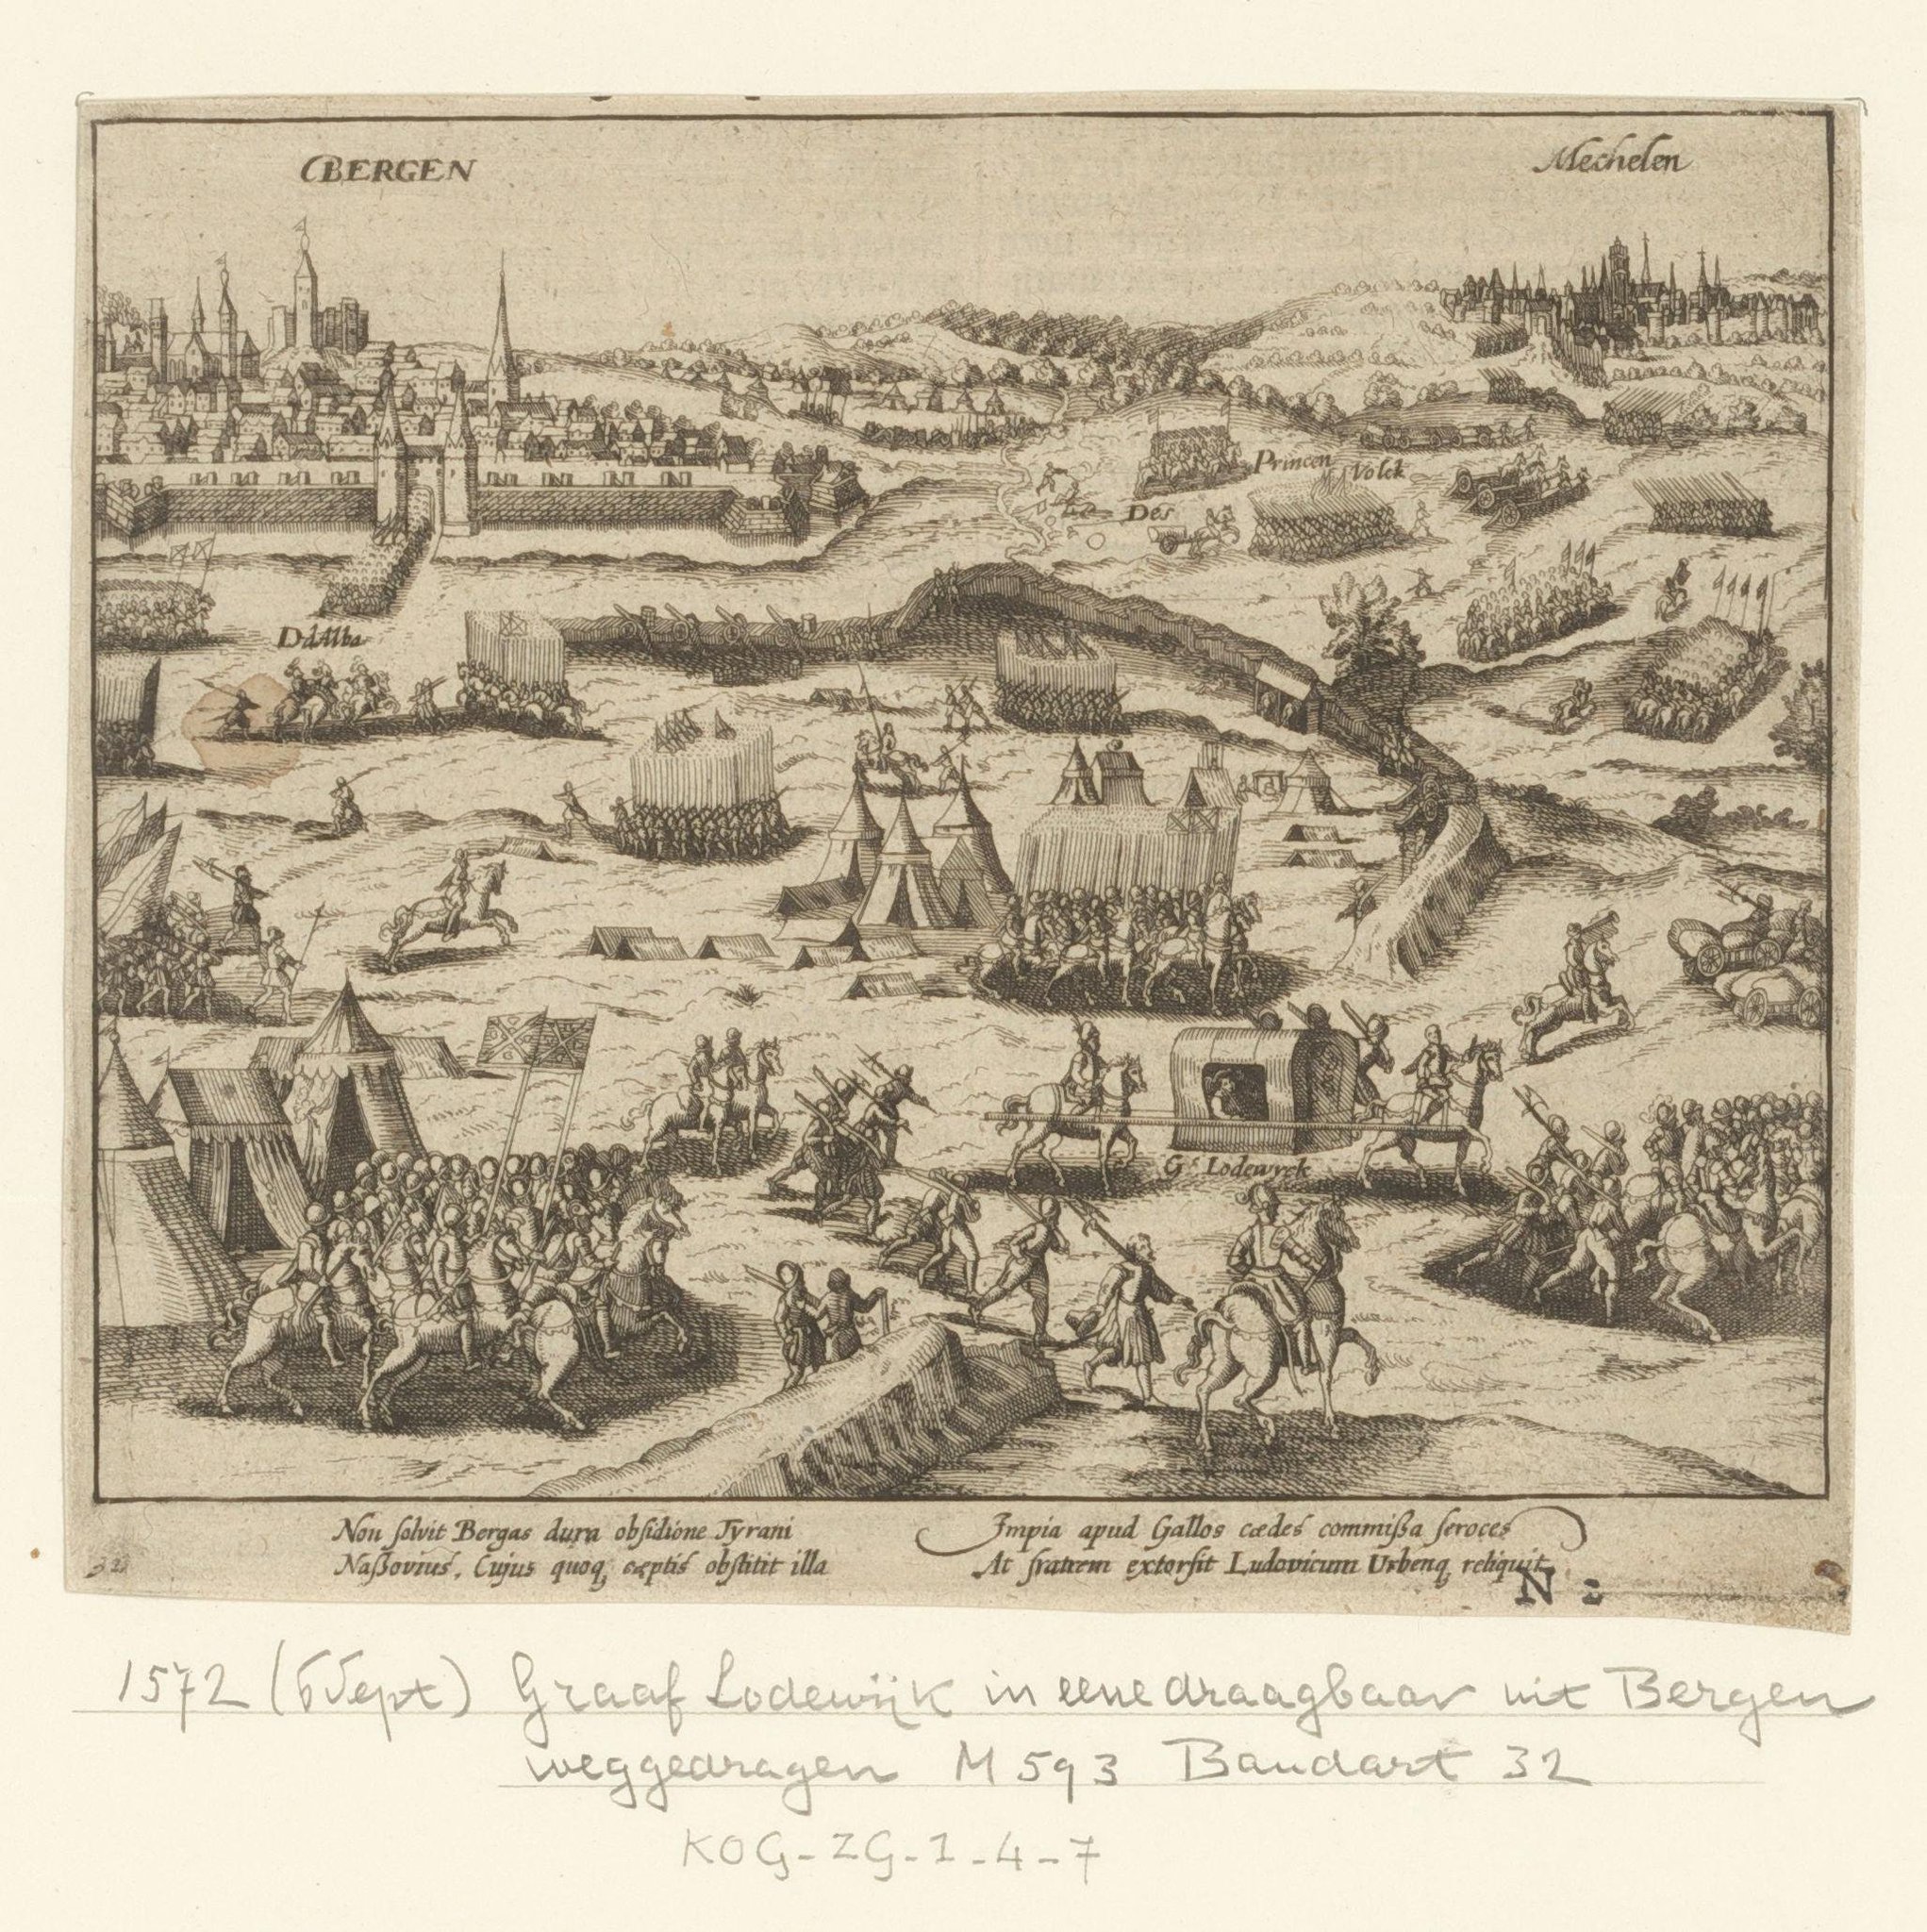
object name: history print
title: Lodewijk van Nassau verlaat Bergen, 1572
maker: Anonymous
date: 1613-1615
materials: paper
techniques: etching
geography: northern netherlands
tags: delft, william i (prince of orange), fernando álvarez de toledo (3rd duke of alba), (carrying a person in a) sedan-chair, capture of city (after the siege)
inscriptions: collector's mark, collector's mark: Lugt 1641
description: Het leger van Lodewijk van Nassau verlaat Bergen, 6 september 1572. Links in de verte neemt het leger van Alva de stad weer in, rechts de aftocht van het leger van de prins richting Mechelen. Op de voorgrond Lodewijk in een draagstoel. Met onderschrift van 4 regels in het Latijn. Genummerd: 32. Bedrukt op achterzijde met tekst in het Nederlands. Onderwerpsrubrieken binnen de Atlas Zeden en Gewoonten: Krijgswezen; prenten van Baudart. 80j. oorlog.